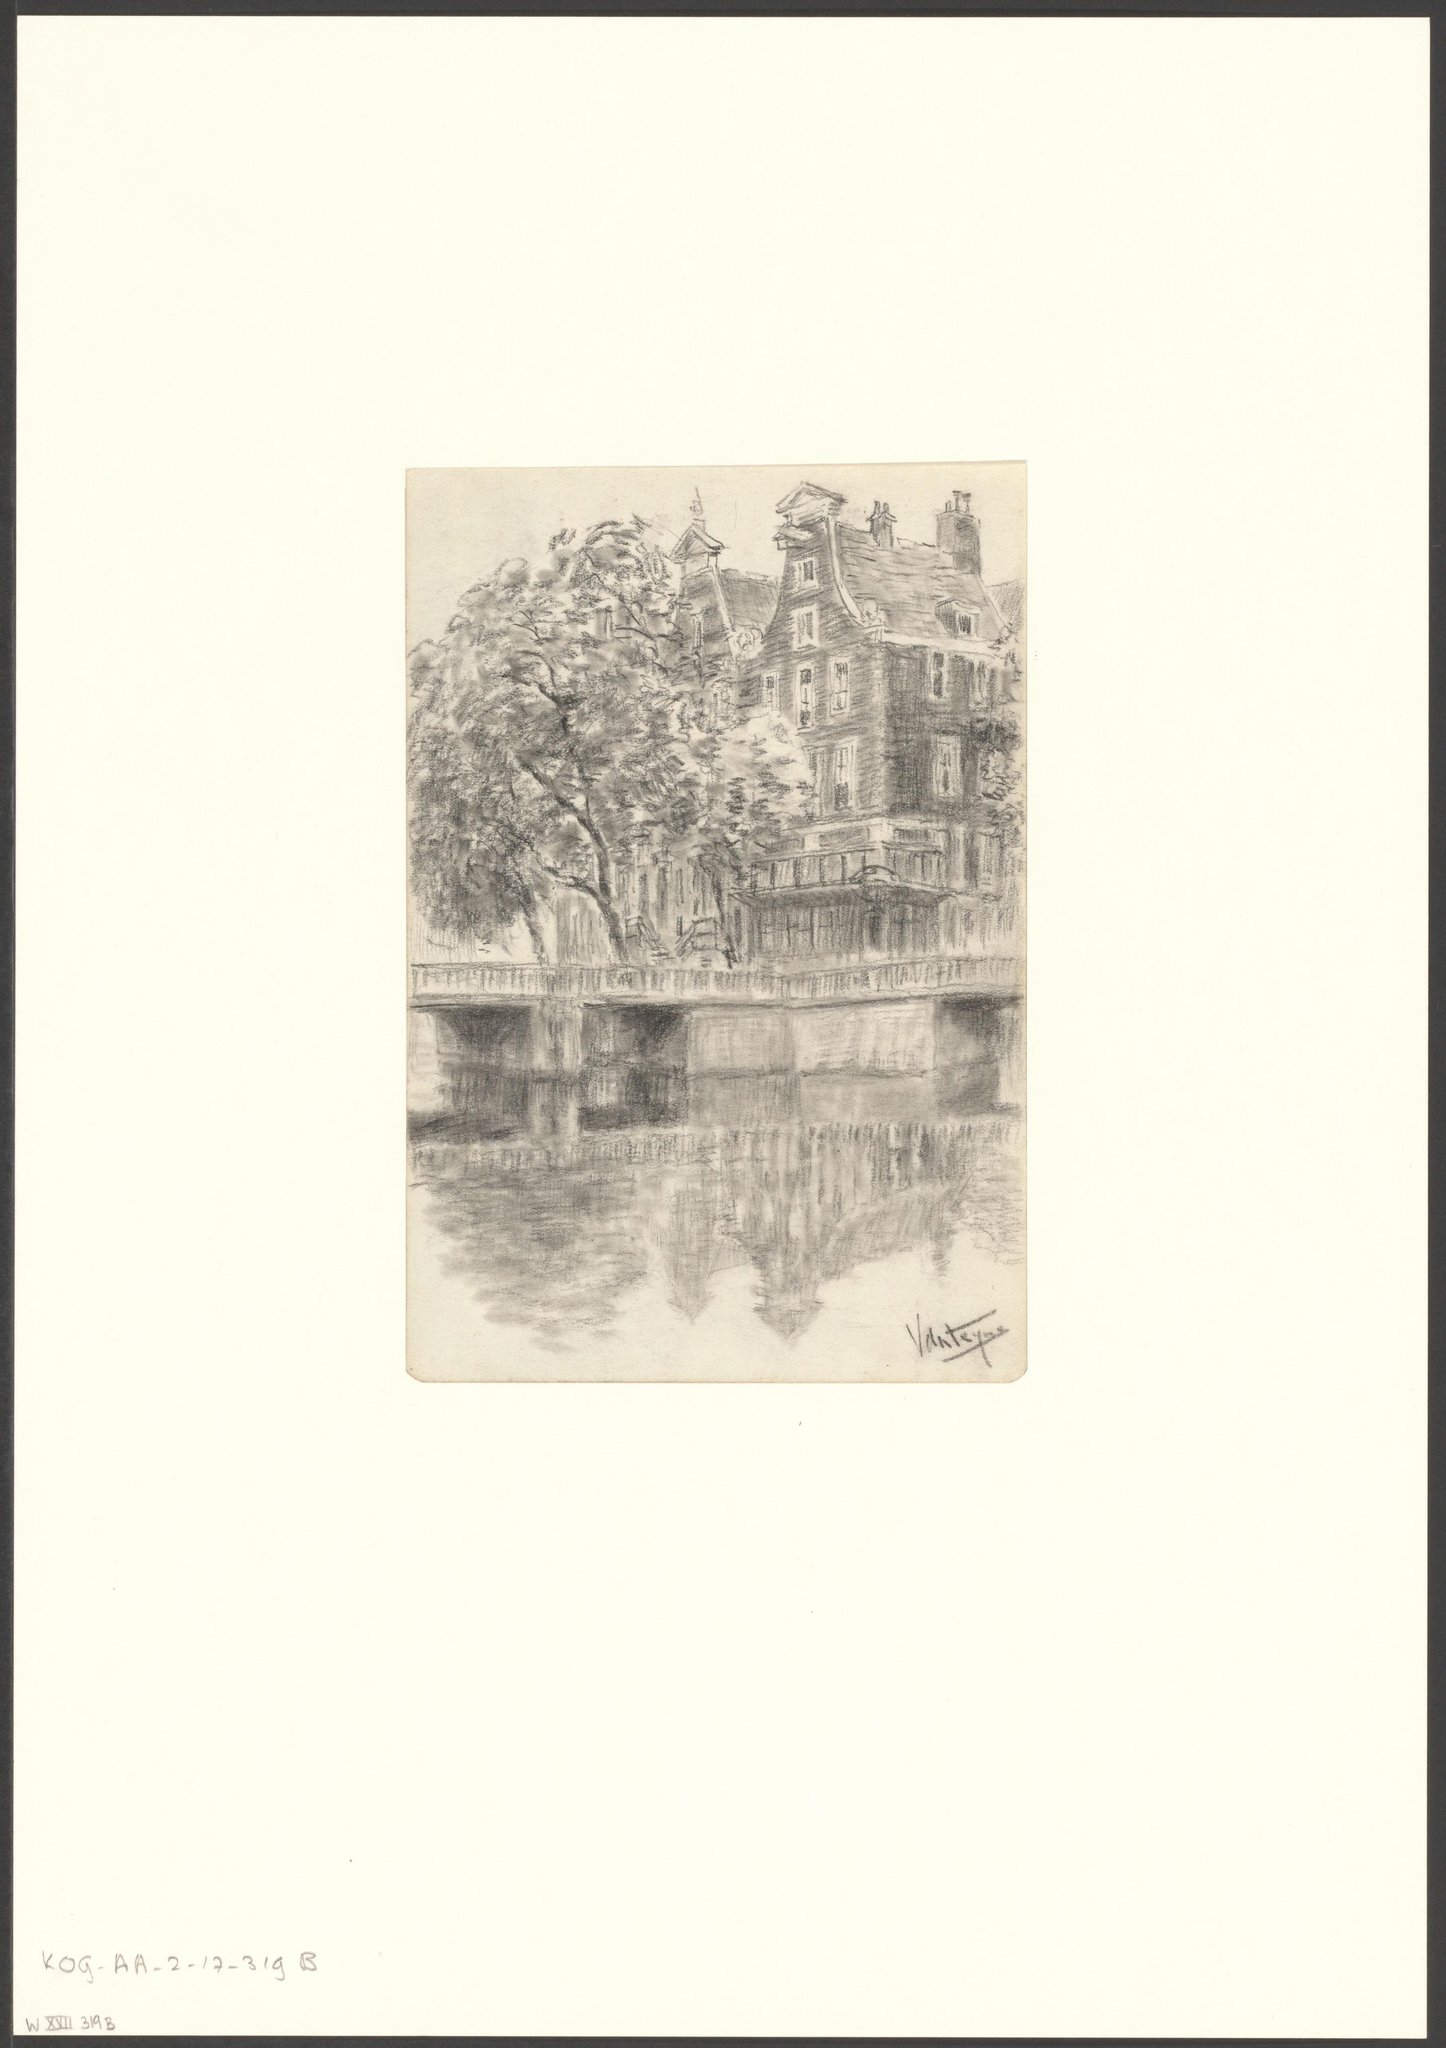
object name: drawing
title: Gezicht op de Keizersgracht, hoek Leidsegracht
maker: anthonie van teijn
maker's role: draughtsman, painter, print maker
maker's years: 1863-1943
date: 1906-1927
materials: chalk, paper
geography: amsterdam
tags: city-view in general; 'veduta', canal, façade (of house or building), bridge in city across river, canal, etc.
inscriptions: inscription: ‘hoek Keizersgracht en / Leidschegracht / Geteekend door Ant van Teyn. Juni 1927 VEck’, signature: ‘VanTeyne’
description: Tekening binnen de Atlas Van Eck ingedeeld op wijknummer 17.